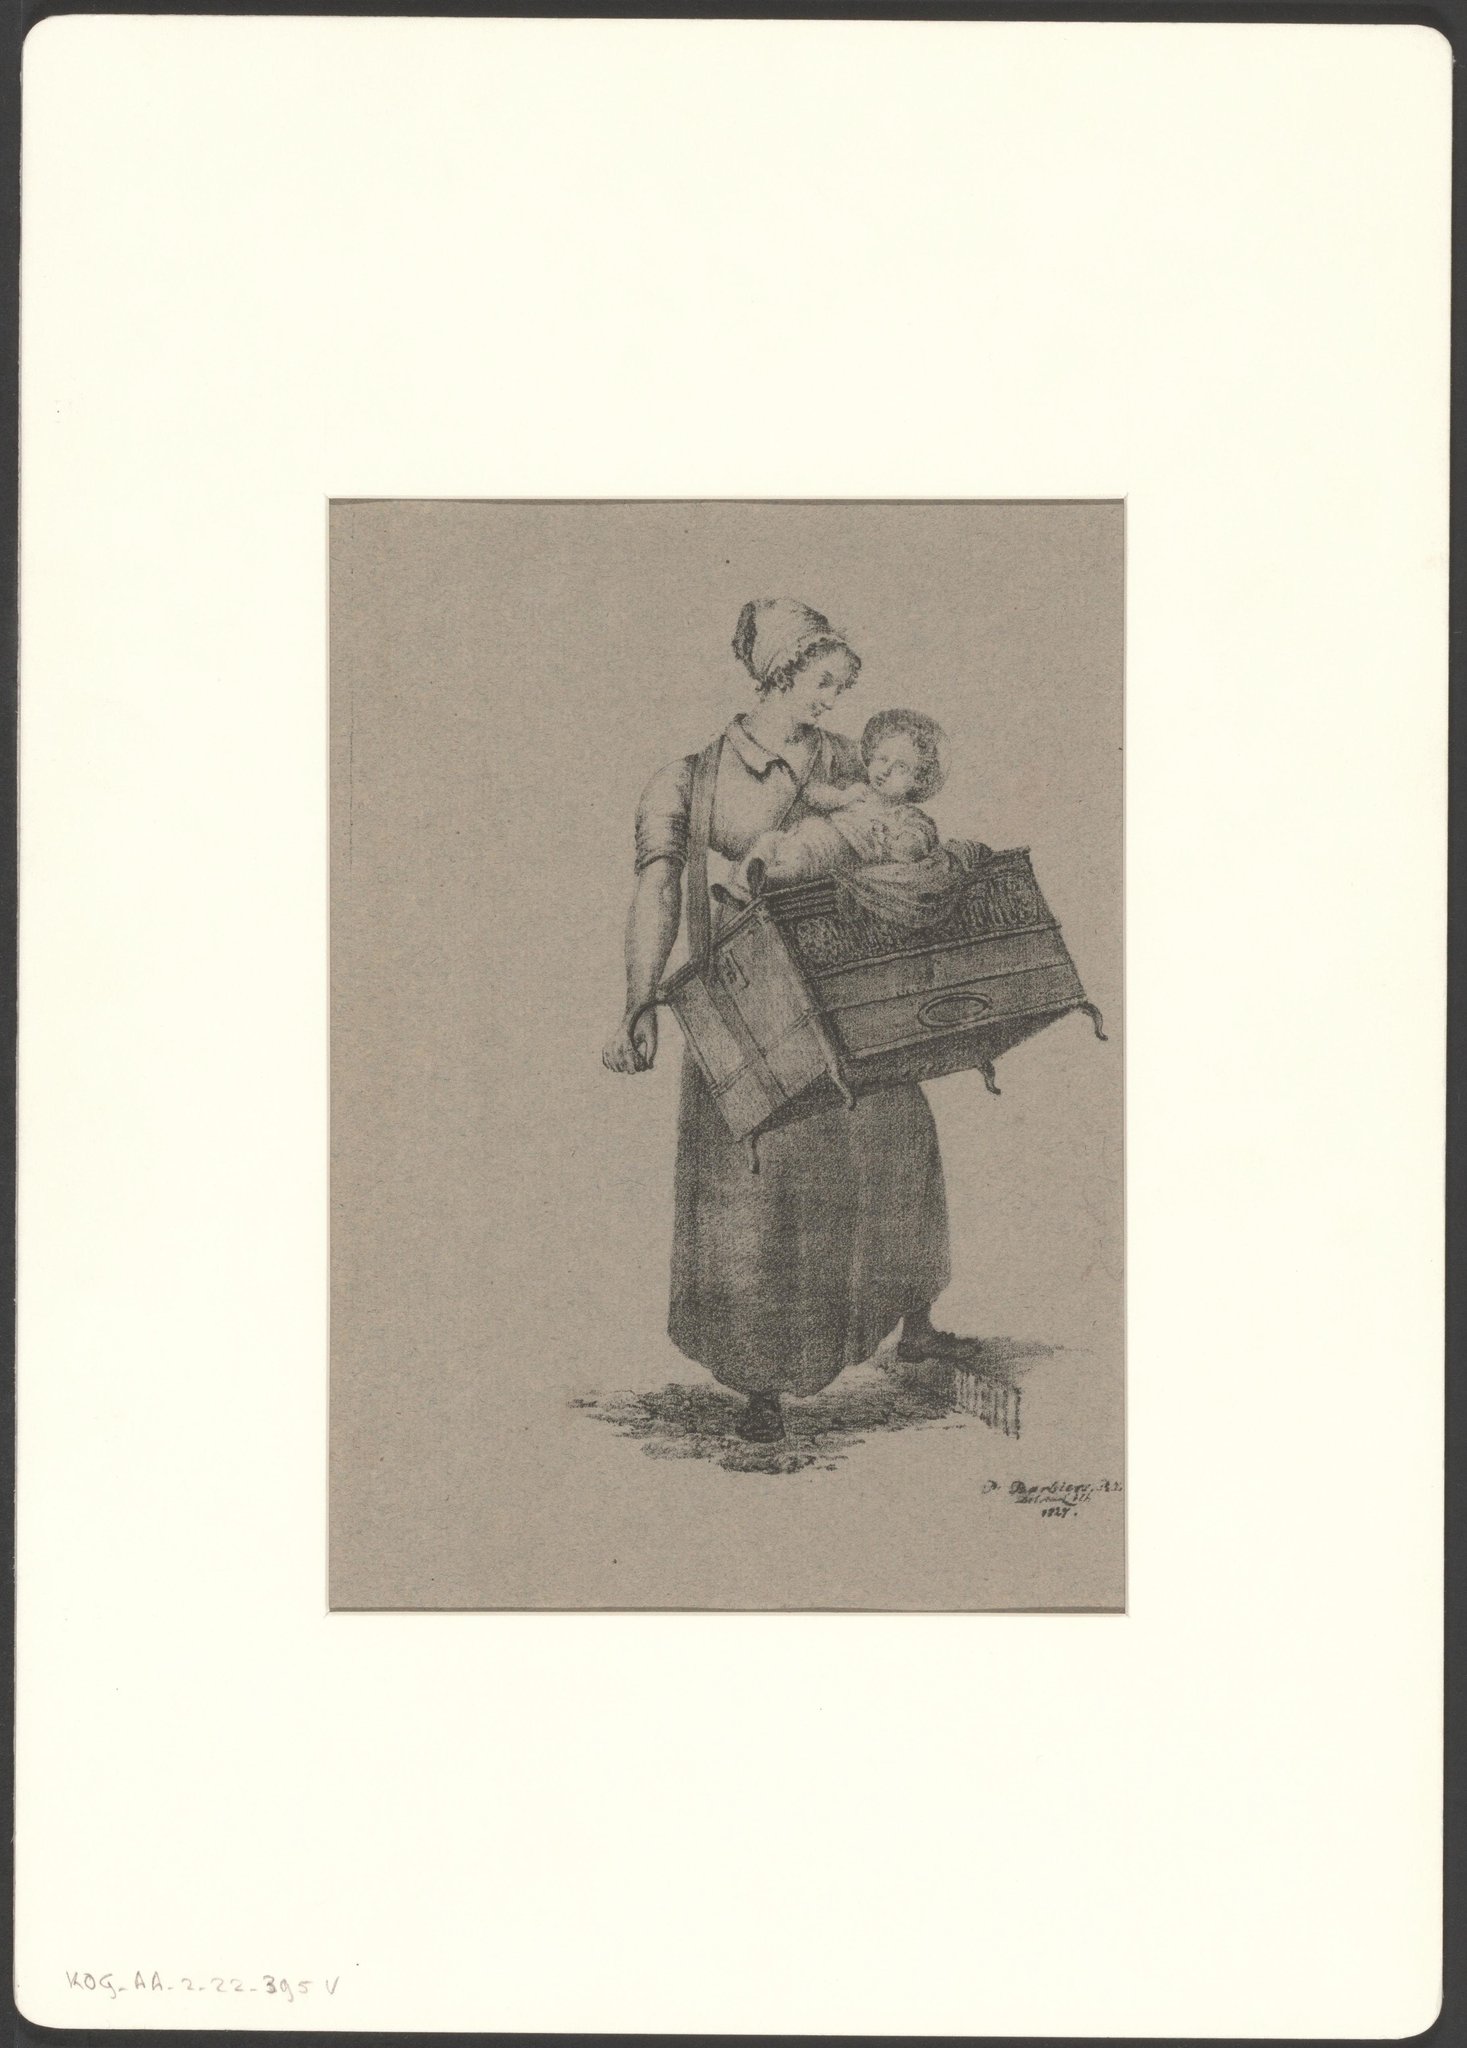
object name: drawing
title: Vrouw met kind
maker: pieter pietersz. barbiers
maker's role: draughtsman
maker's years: 1749-1842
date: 1827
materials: chalk, paper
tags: chest, coffer, mother and child(ren), woman and child(ren) (family group)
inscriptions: signature and date: ‘P. Barbiers. Pz. / Delineavit / 1827.’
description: Tekening binnen de Atlas Van Eck ingedeeld op wijknummer 22.